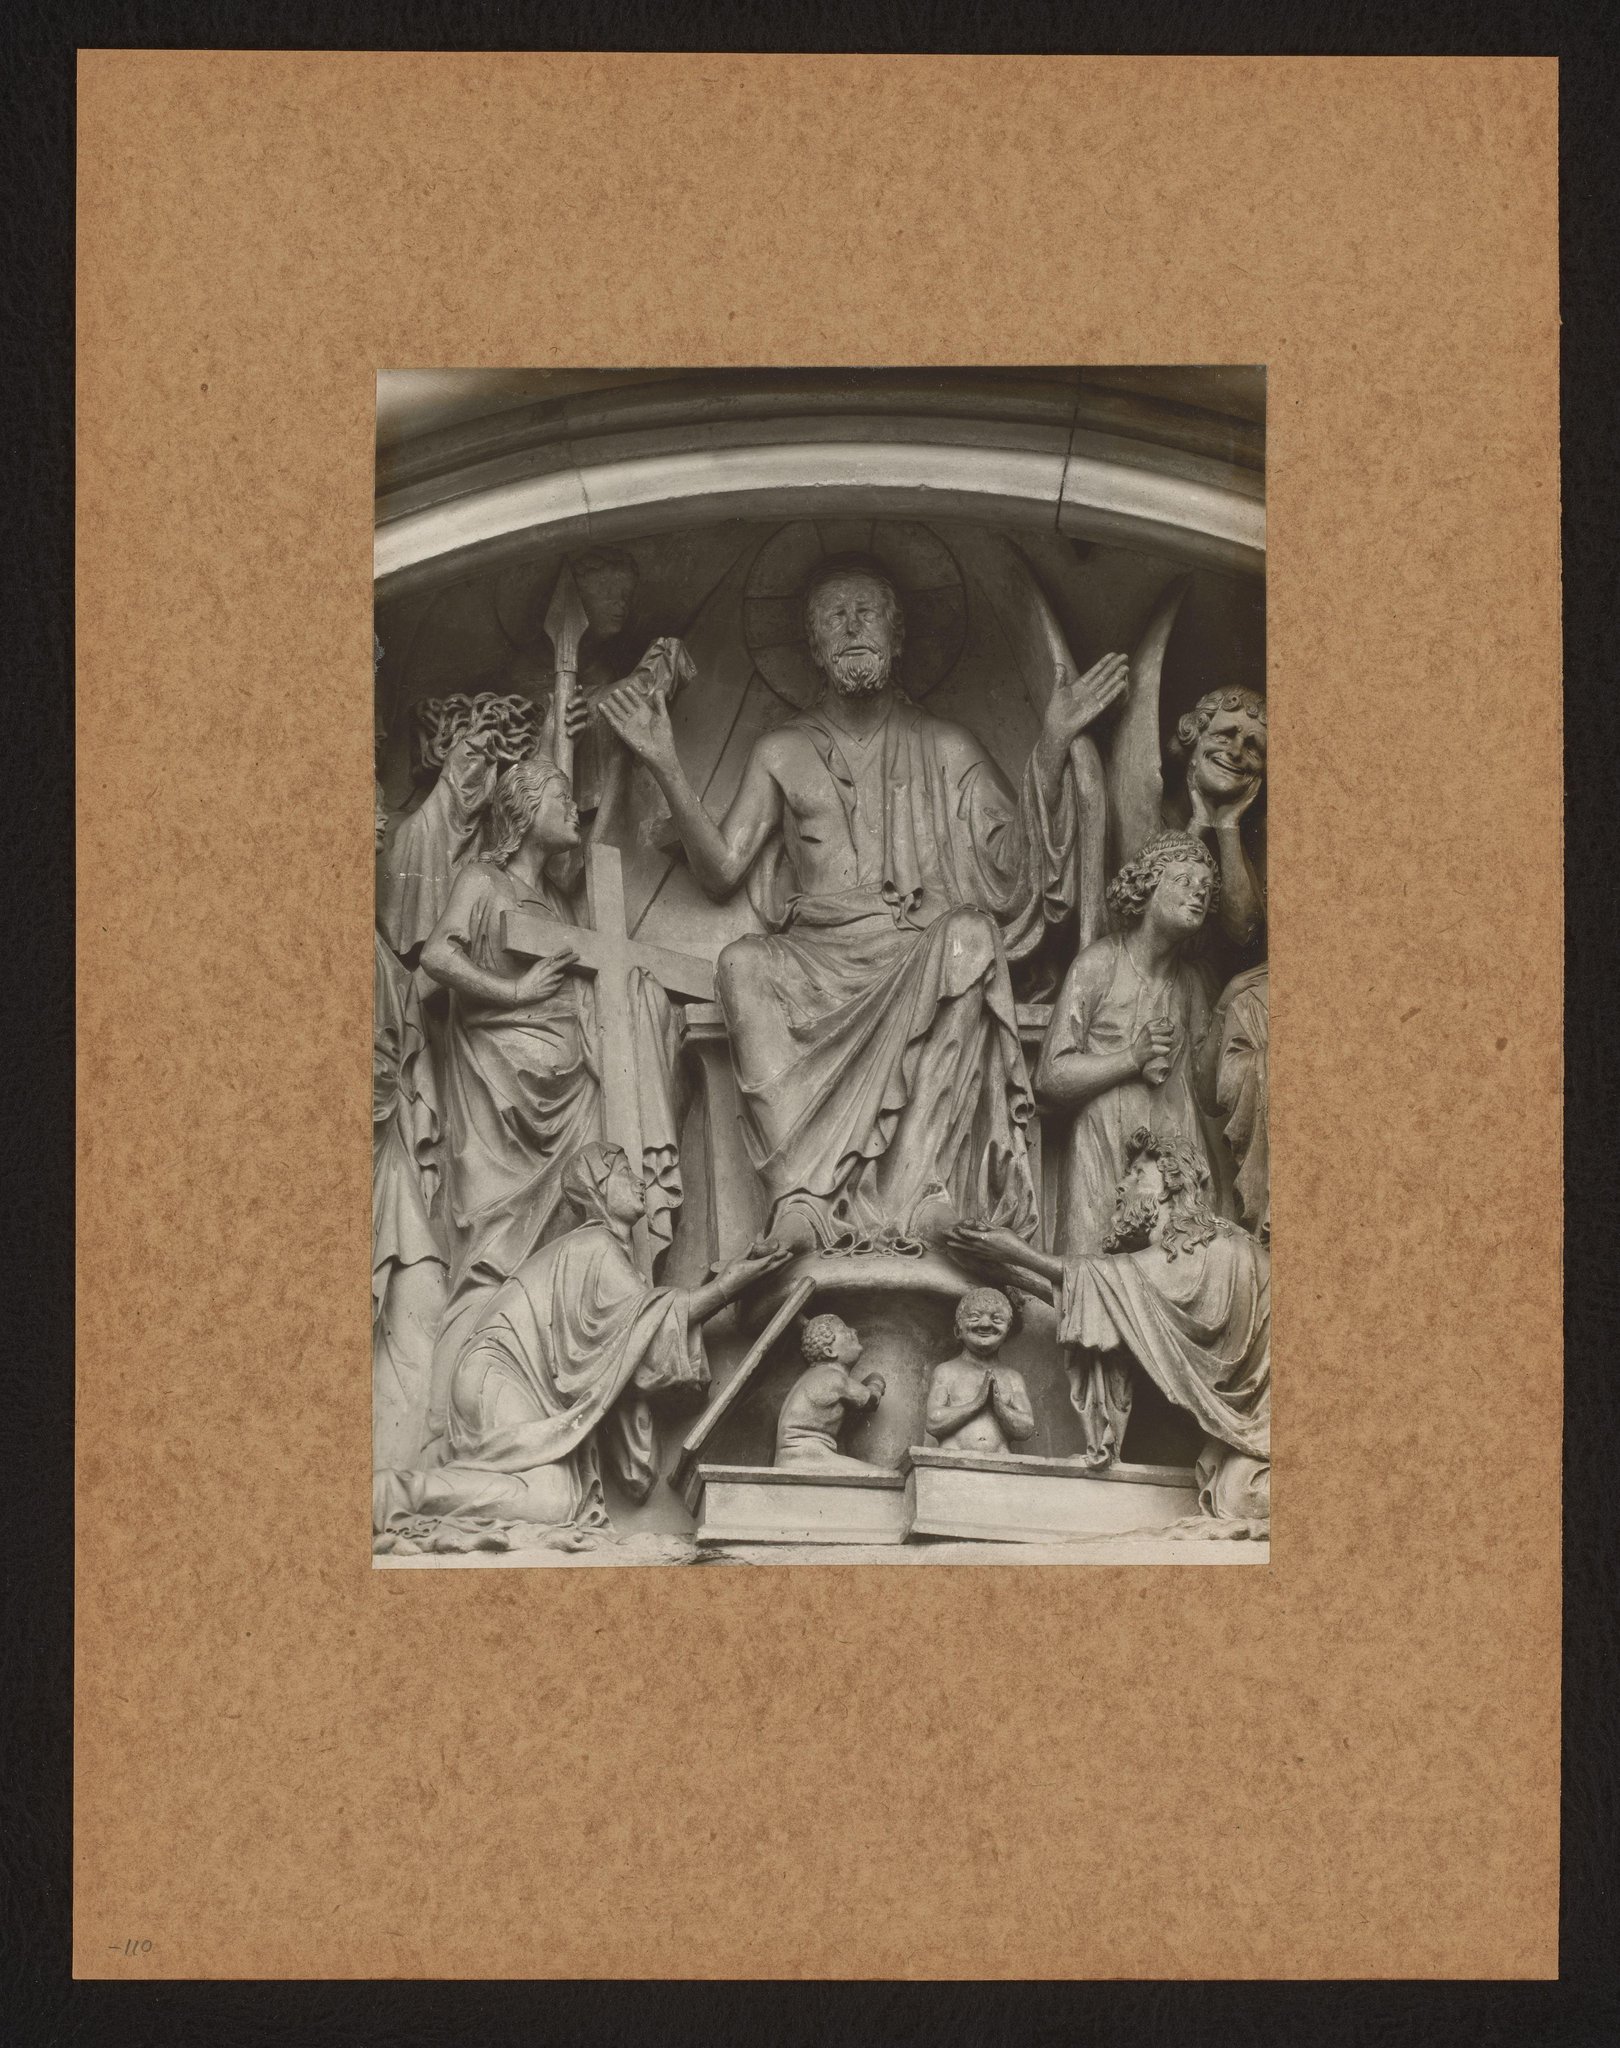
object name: album leaf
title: Fürstentor, Tymphanon, Christus v.vorn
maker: Anonymous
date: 1900-1920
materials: paper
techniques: gelatin silver print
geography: bamberg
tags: church (exterior)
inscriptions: number: ‘113’